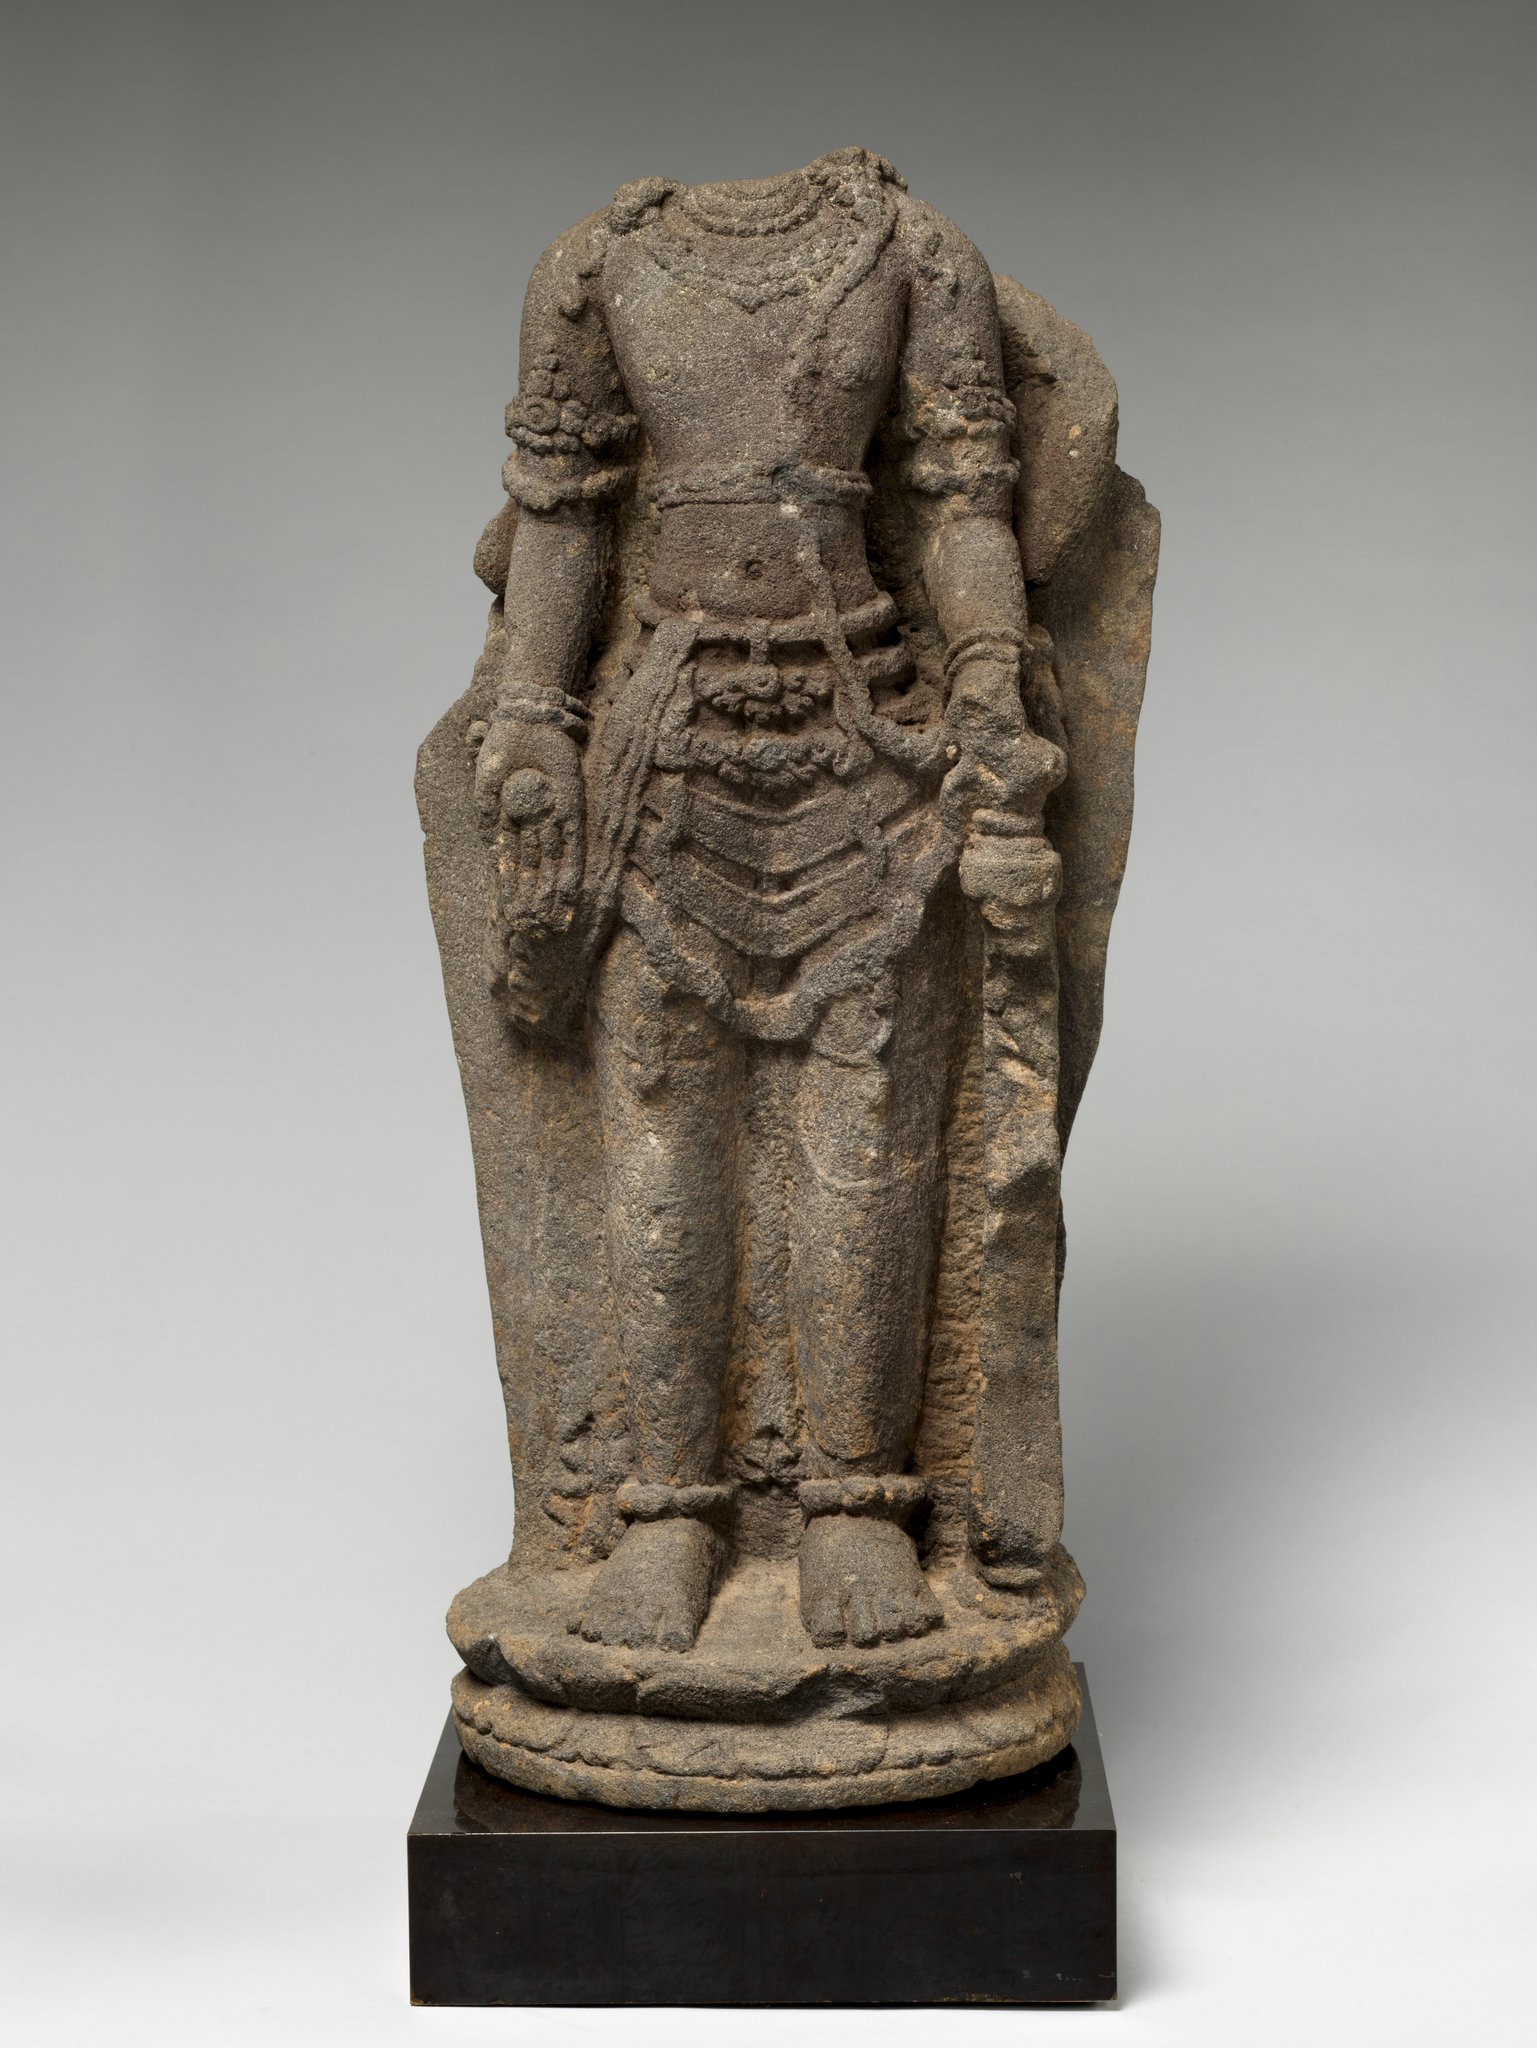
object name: headless figure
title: Standing Vishnu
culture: indonesian, javanese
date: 801-900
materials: stone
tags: vishnu